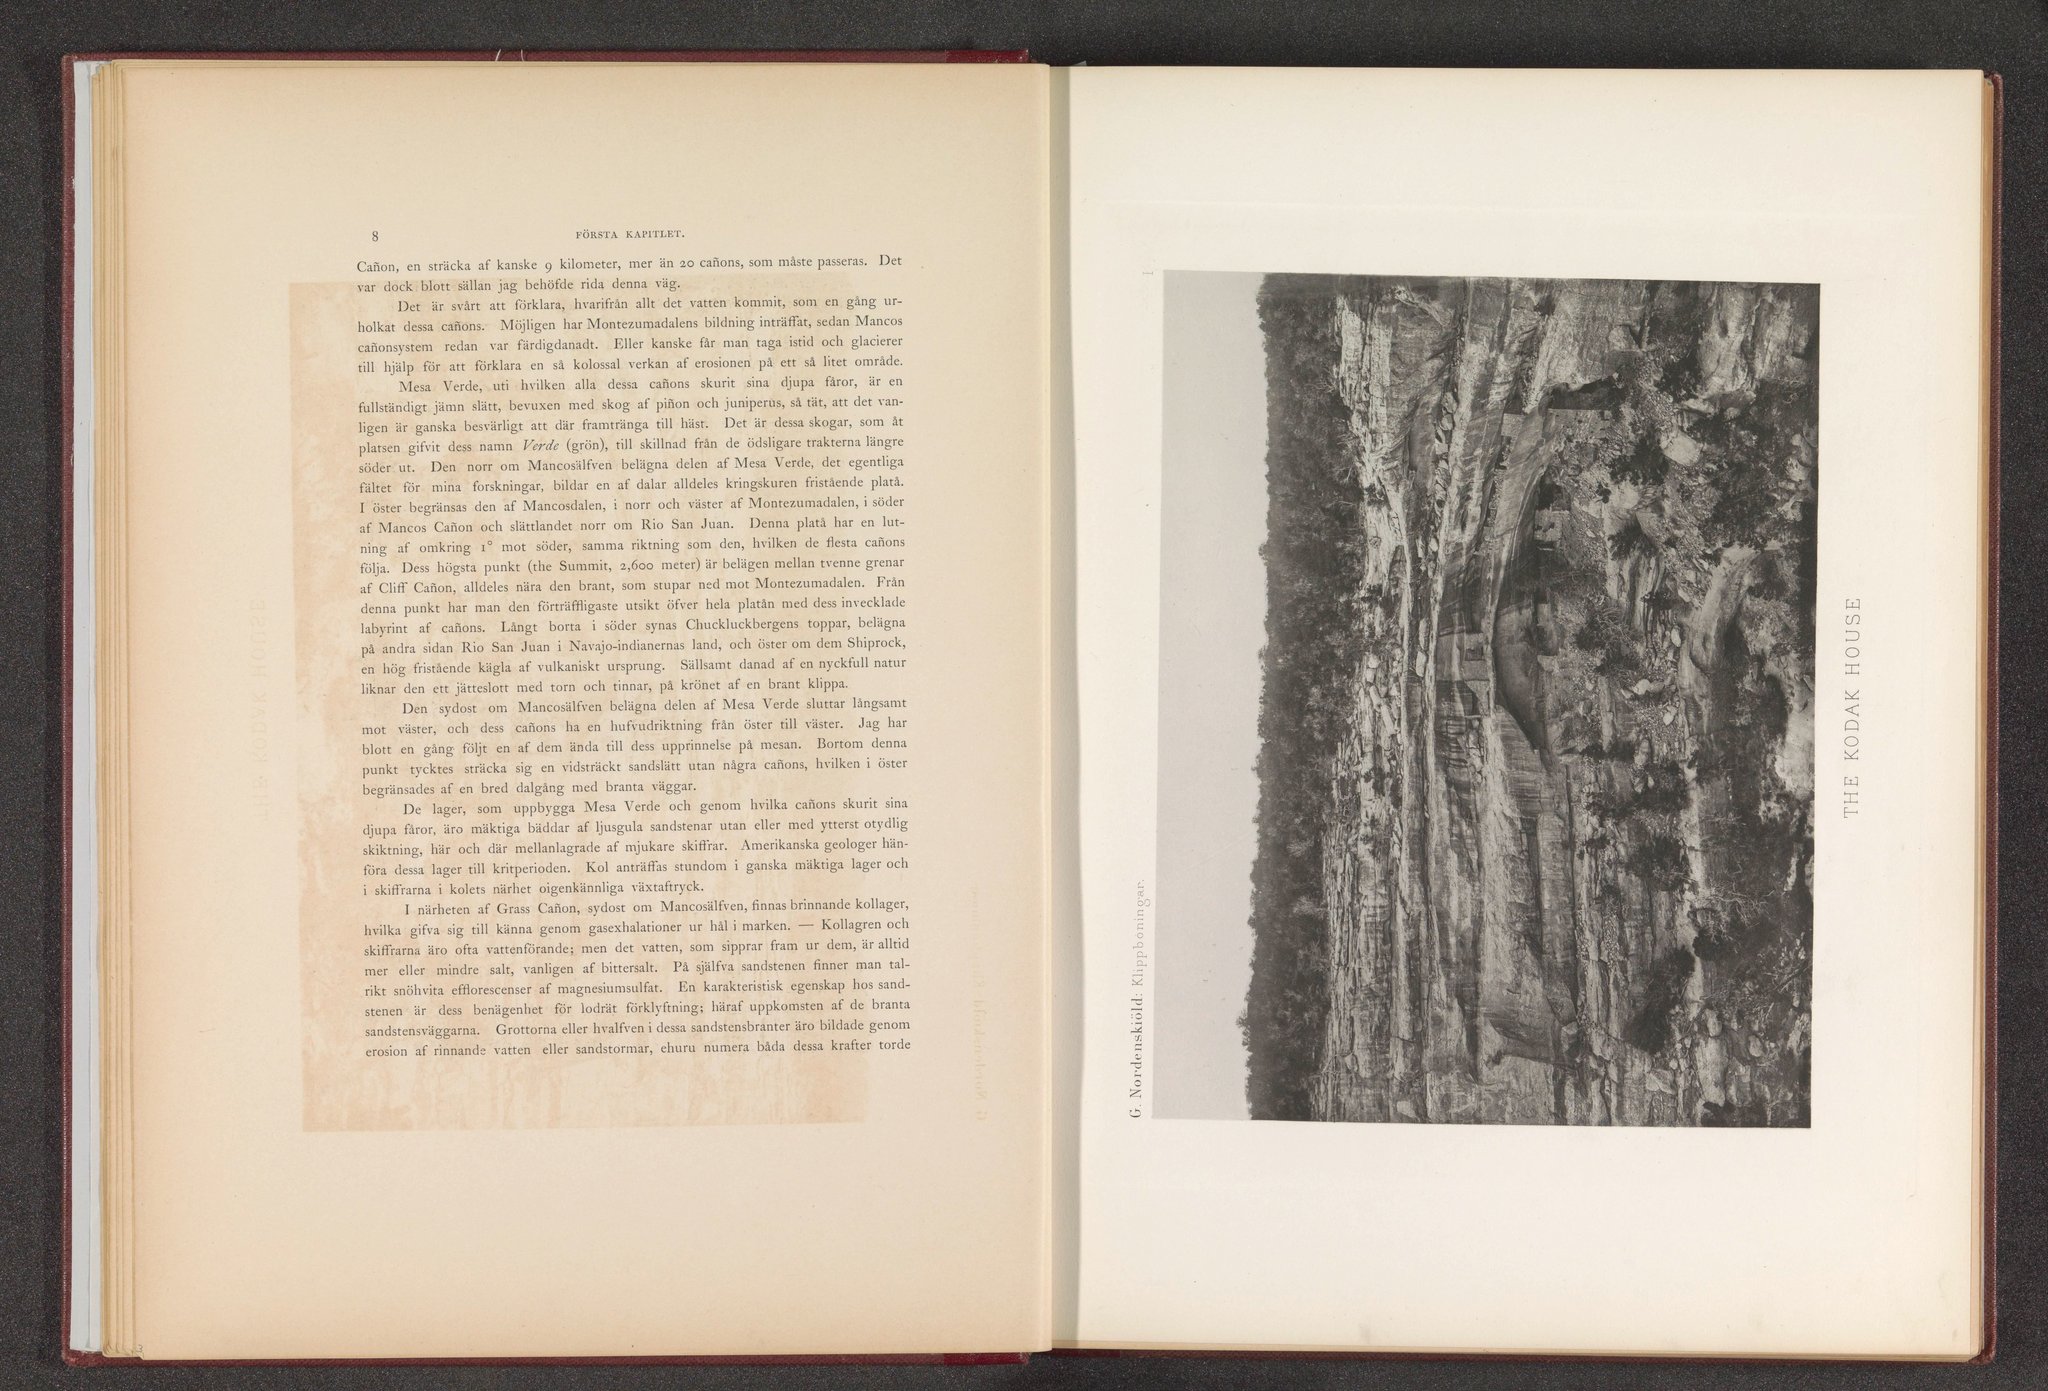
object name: page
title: Gezicht op een rotswoning, Kodak House, in Mesa Verde National Park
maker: gustaf nordenskiöld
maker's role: fotograaf, schrijver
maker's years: 1868-1895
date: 1891-1893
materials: paper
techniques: photoaquatint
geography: mesa verde national park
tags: ruin of a dwelling, house, castle, etc.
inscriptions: number: ‘I’, inscription: ‘G. Nordenskiöld: Klippboningar.’